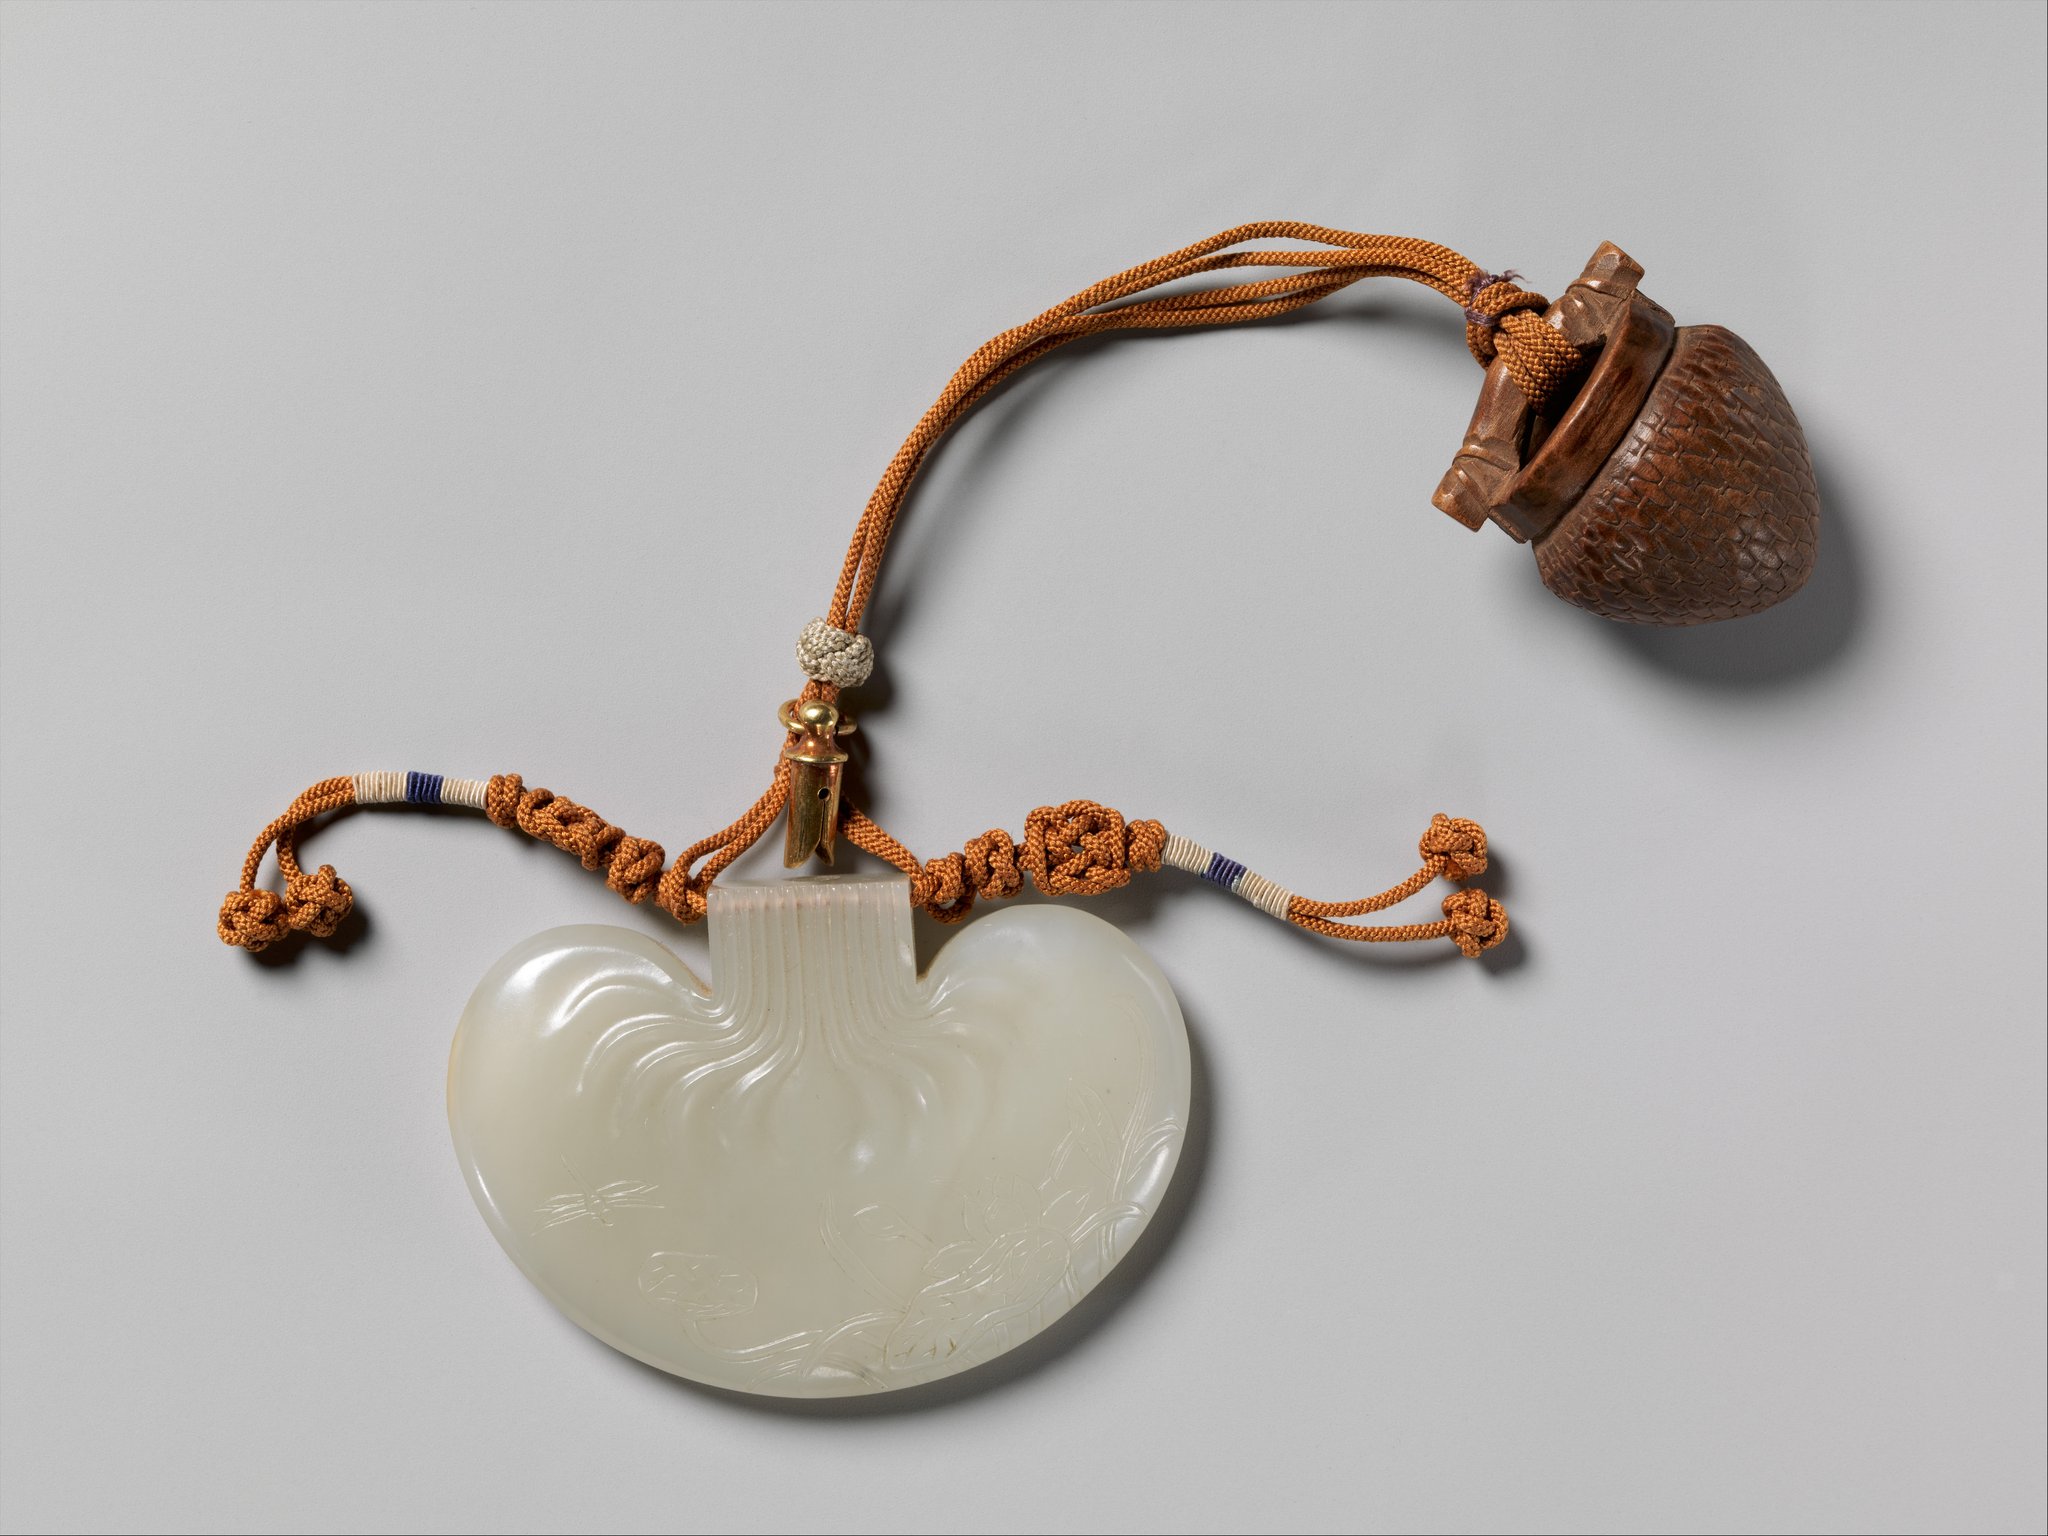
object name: pendant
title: Pendant in the form of a flower bud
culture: chinese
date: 1701-1800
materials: jade